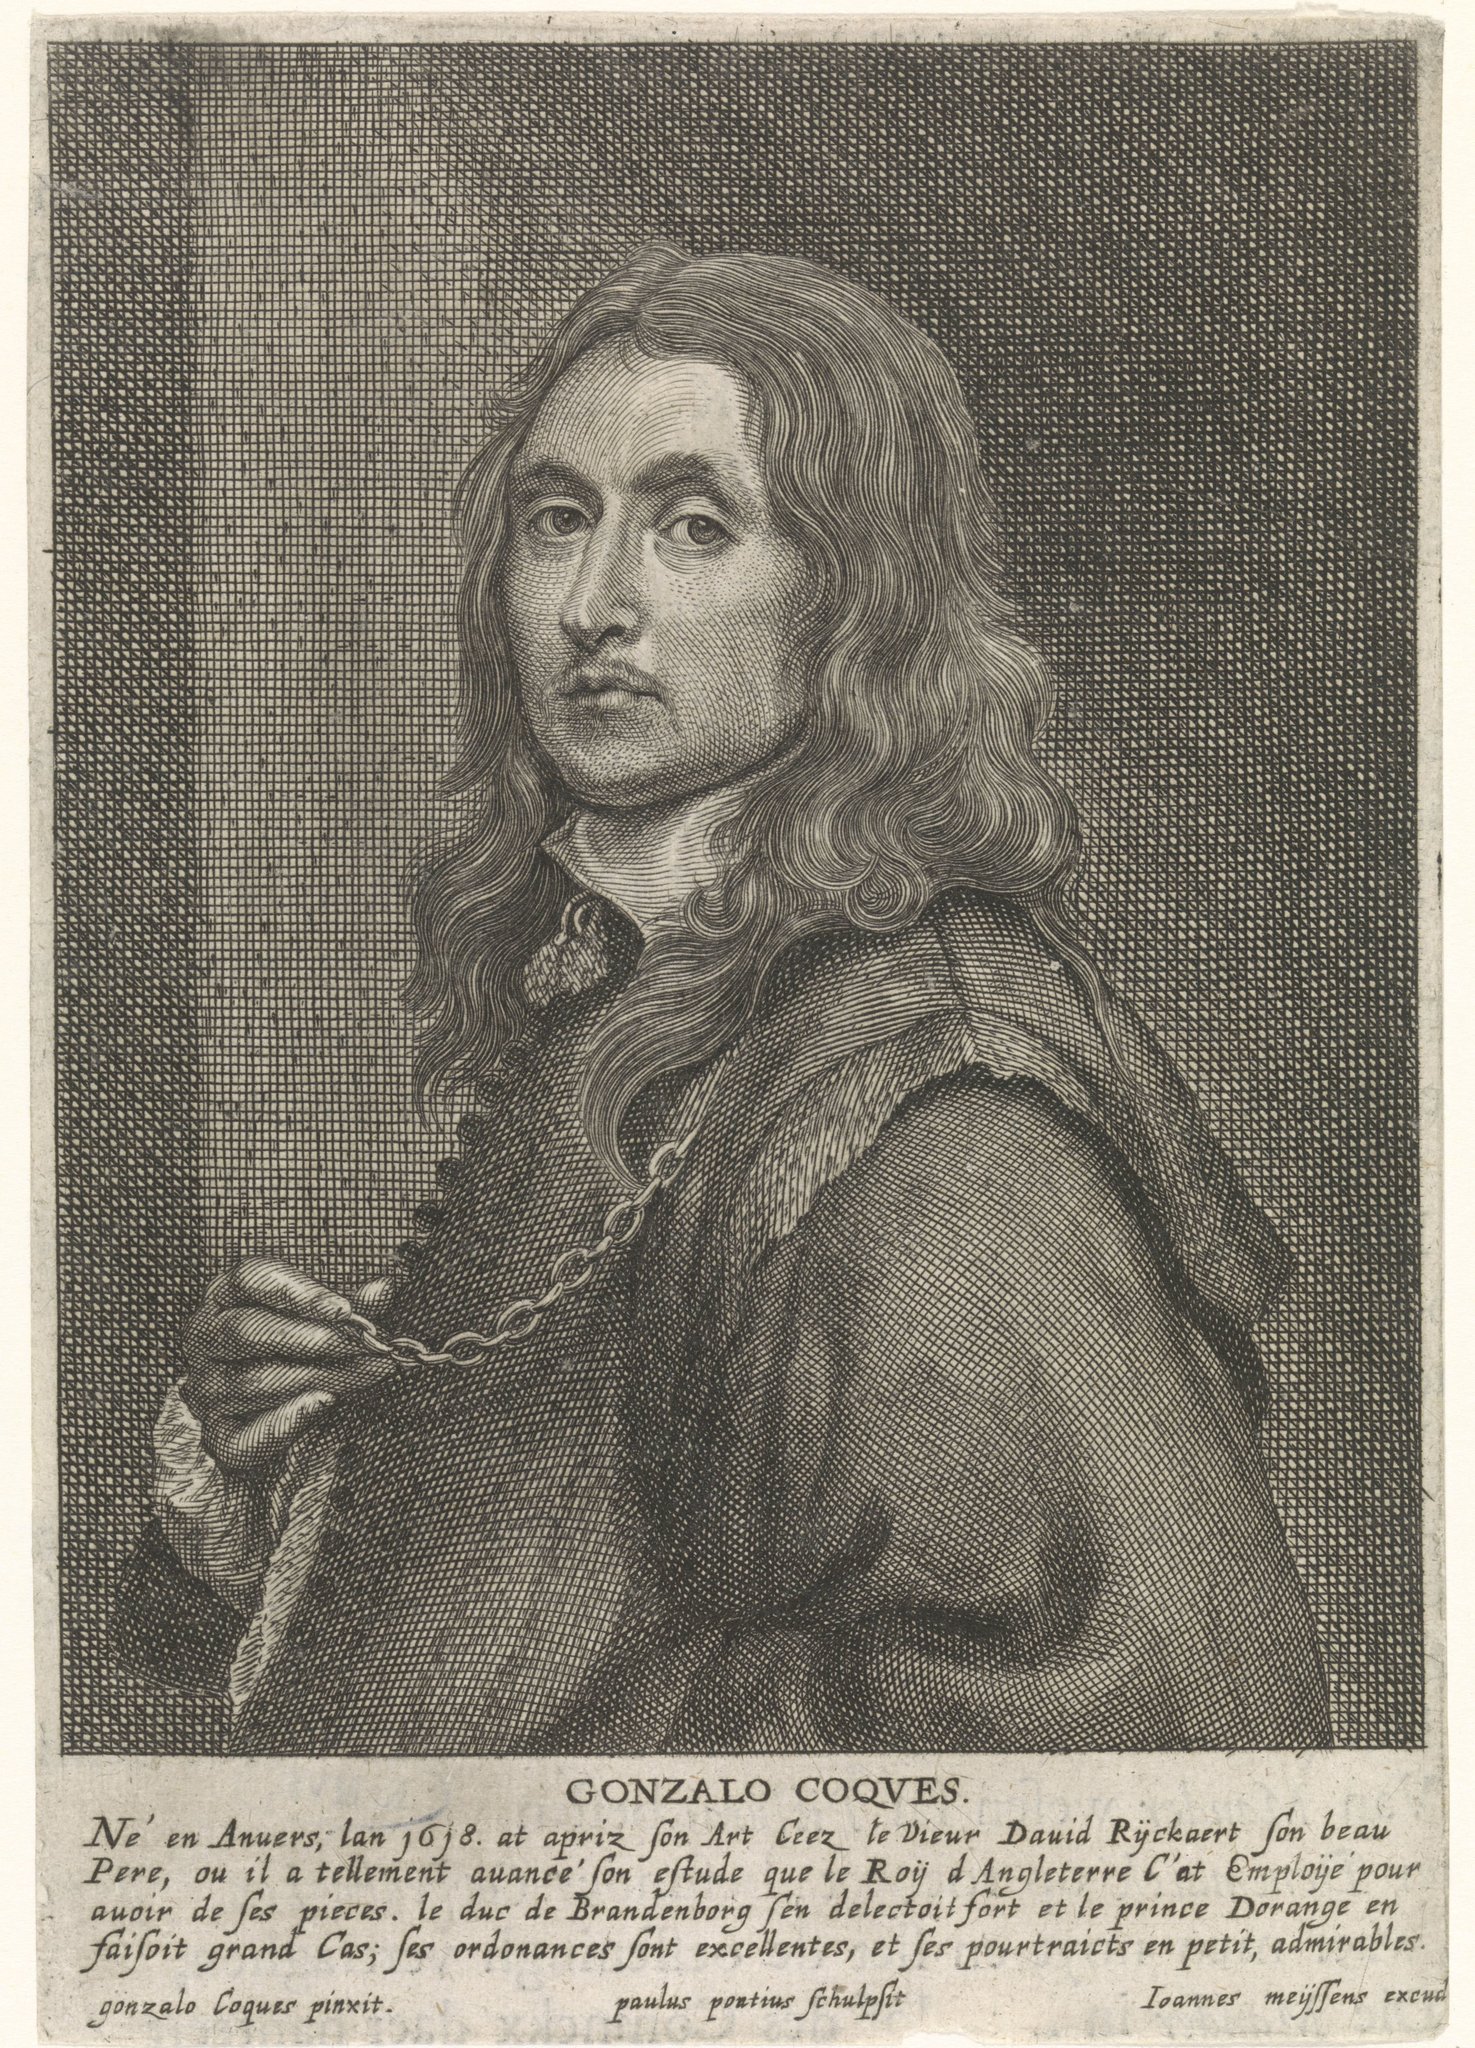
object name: print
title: Portret van de schilder Gonzales Coques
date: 1616-1657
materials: paper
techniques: engraving, letterpress printing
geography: antwerp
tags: antwerp, painter, draughtsman, gonzales coques, portrait, self-portrait of painter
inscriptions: collector's mark: Lugt 2228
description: Prent ook opgenomen in: Bie, Cornelis de. Het gulden cabinet vande edele vry schilder-const. Antwerpen: Joannes Meyssens, 1662.